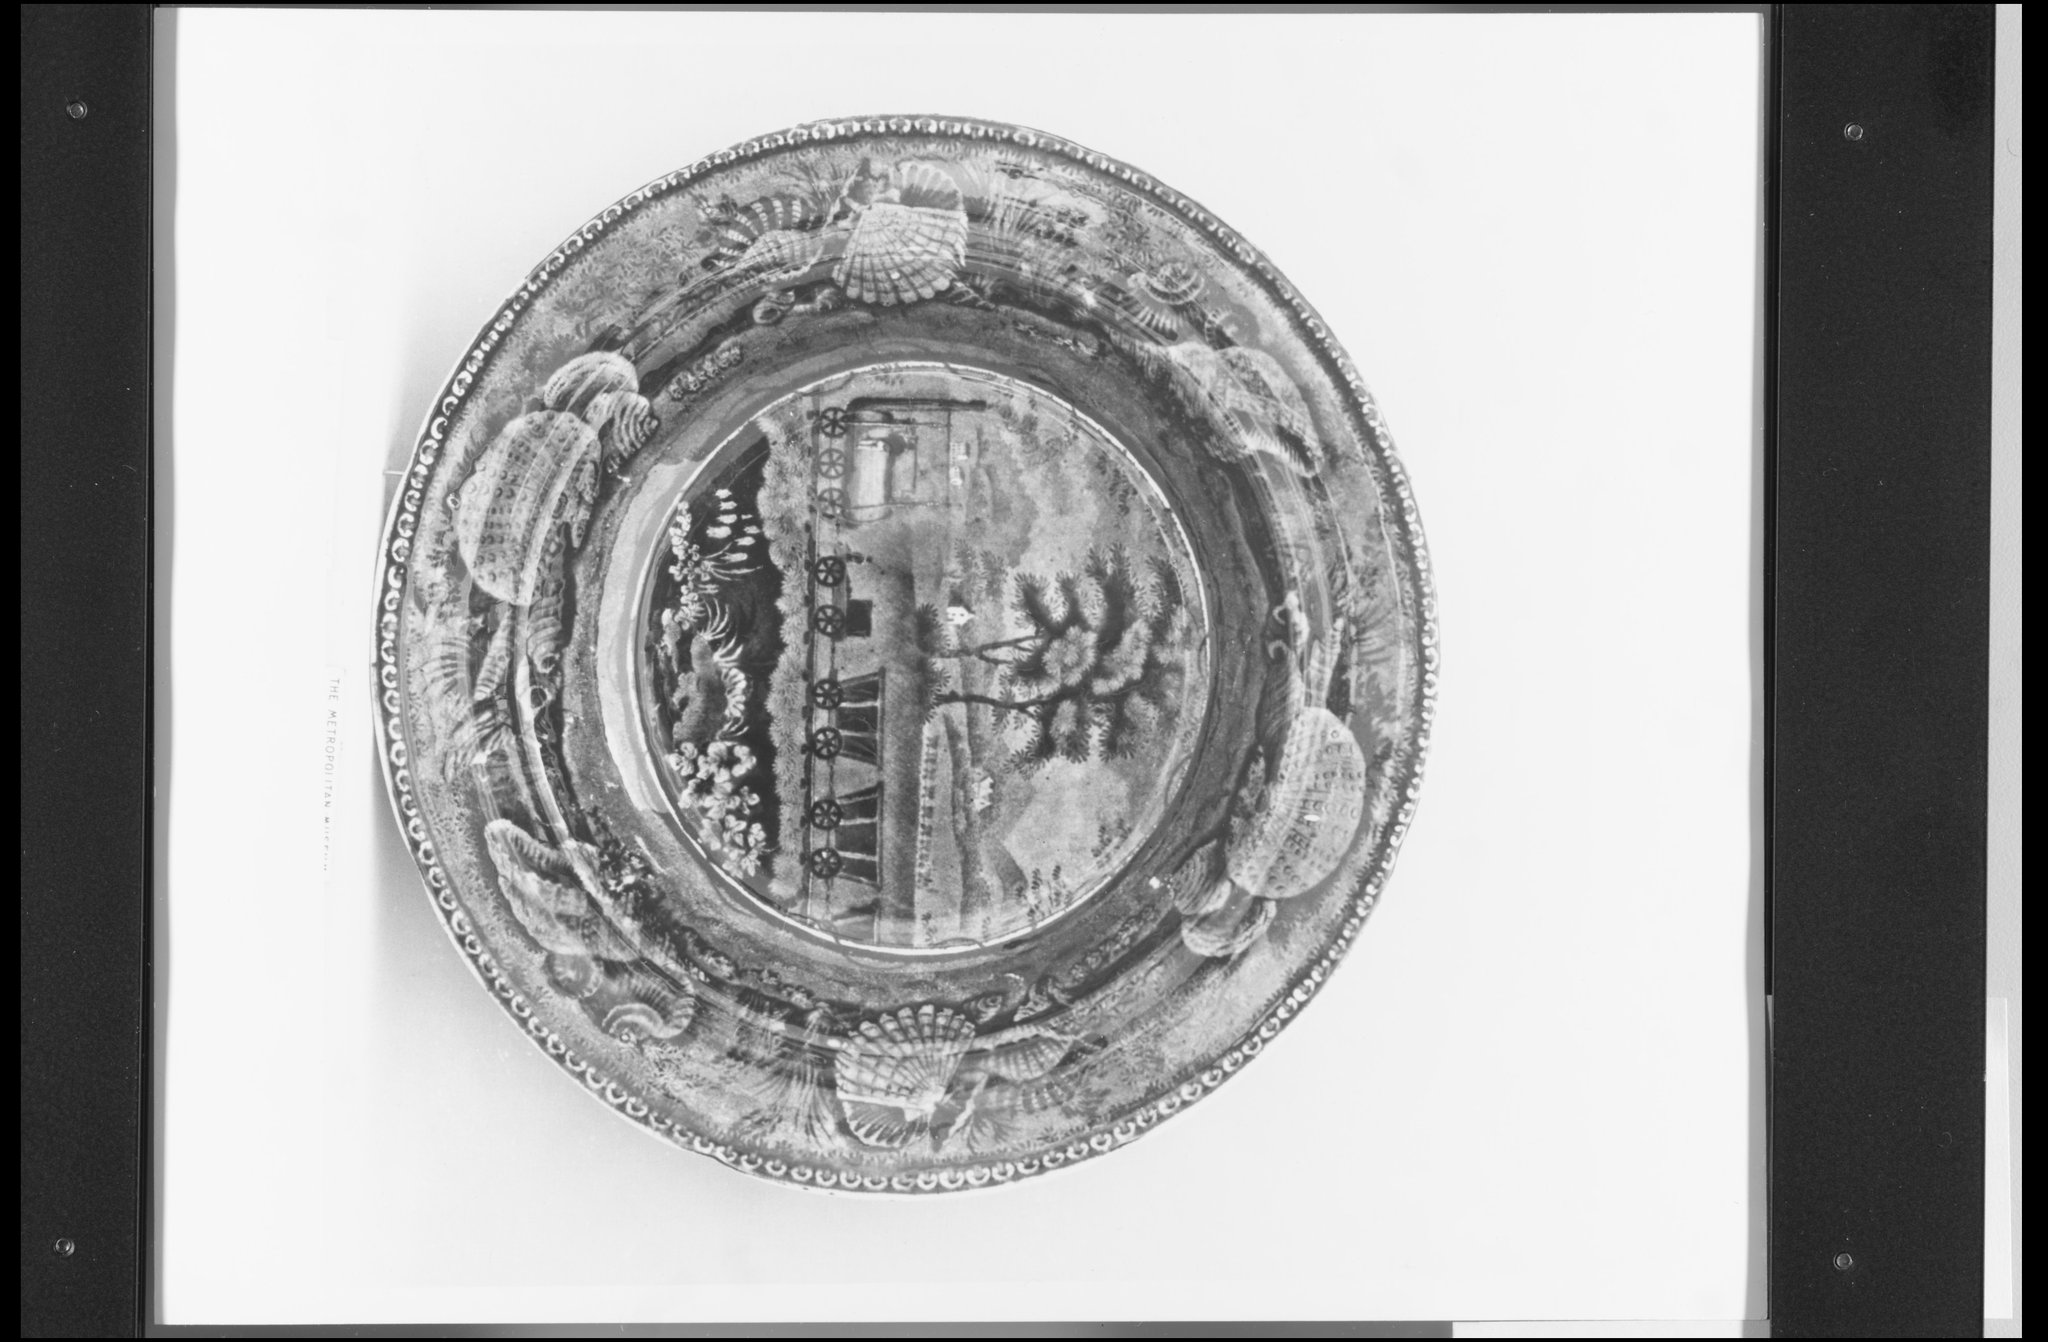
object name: plate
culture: british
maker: enoch wood & sons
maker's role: maker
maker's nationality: british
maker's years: 1818-1846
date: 1828-1846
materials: earthenware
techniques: transfer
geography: england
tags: landscapes,shells,trains